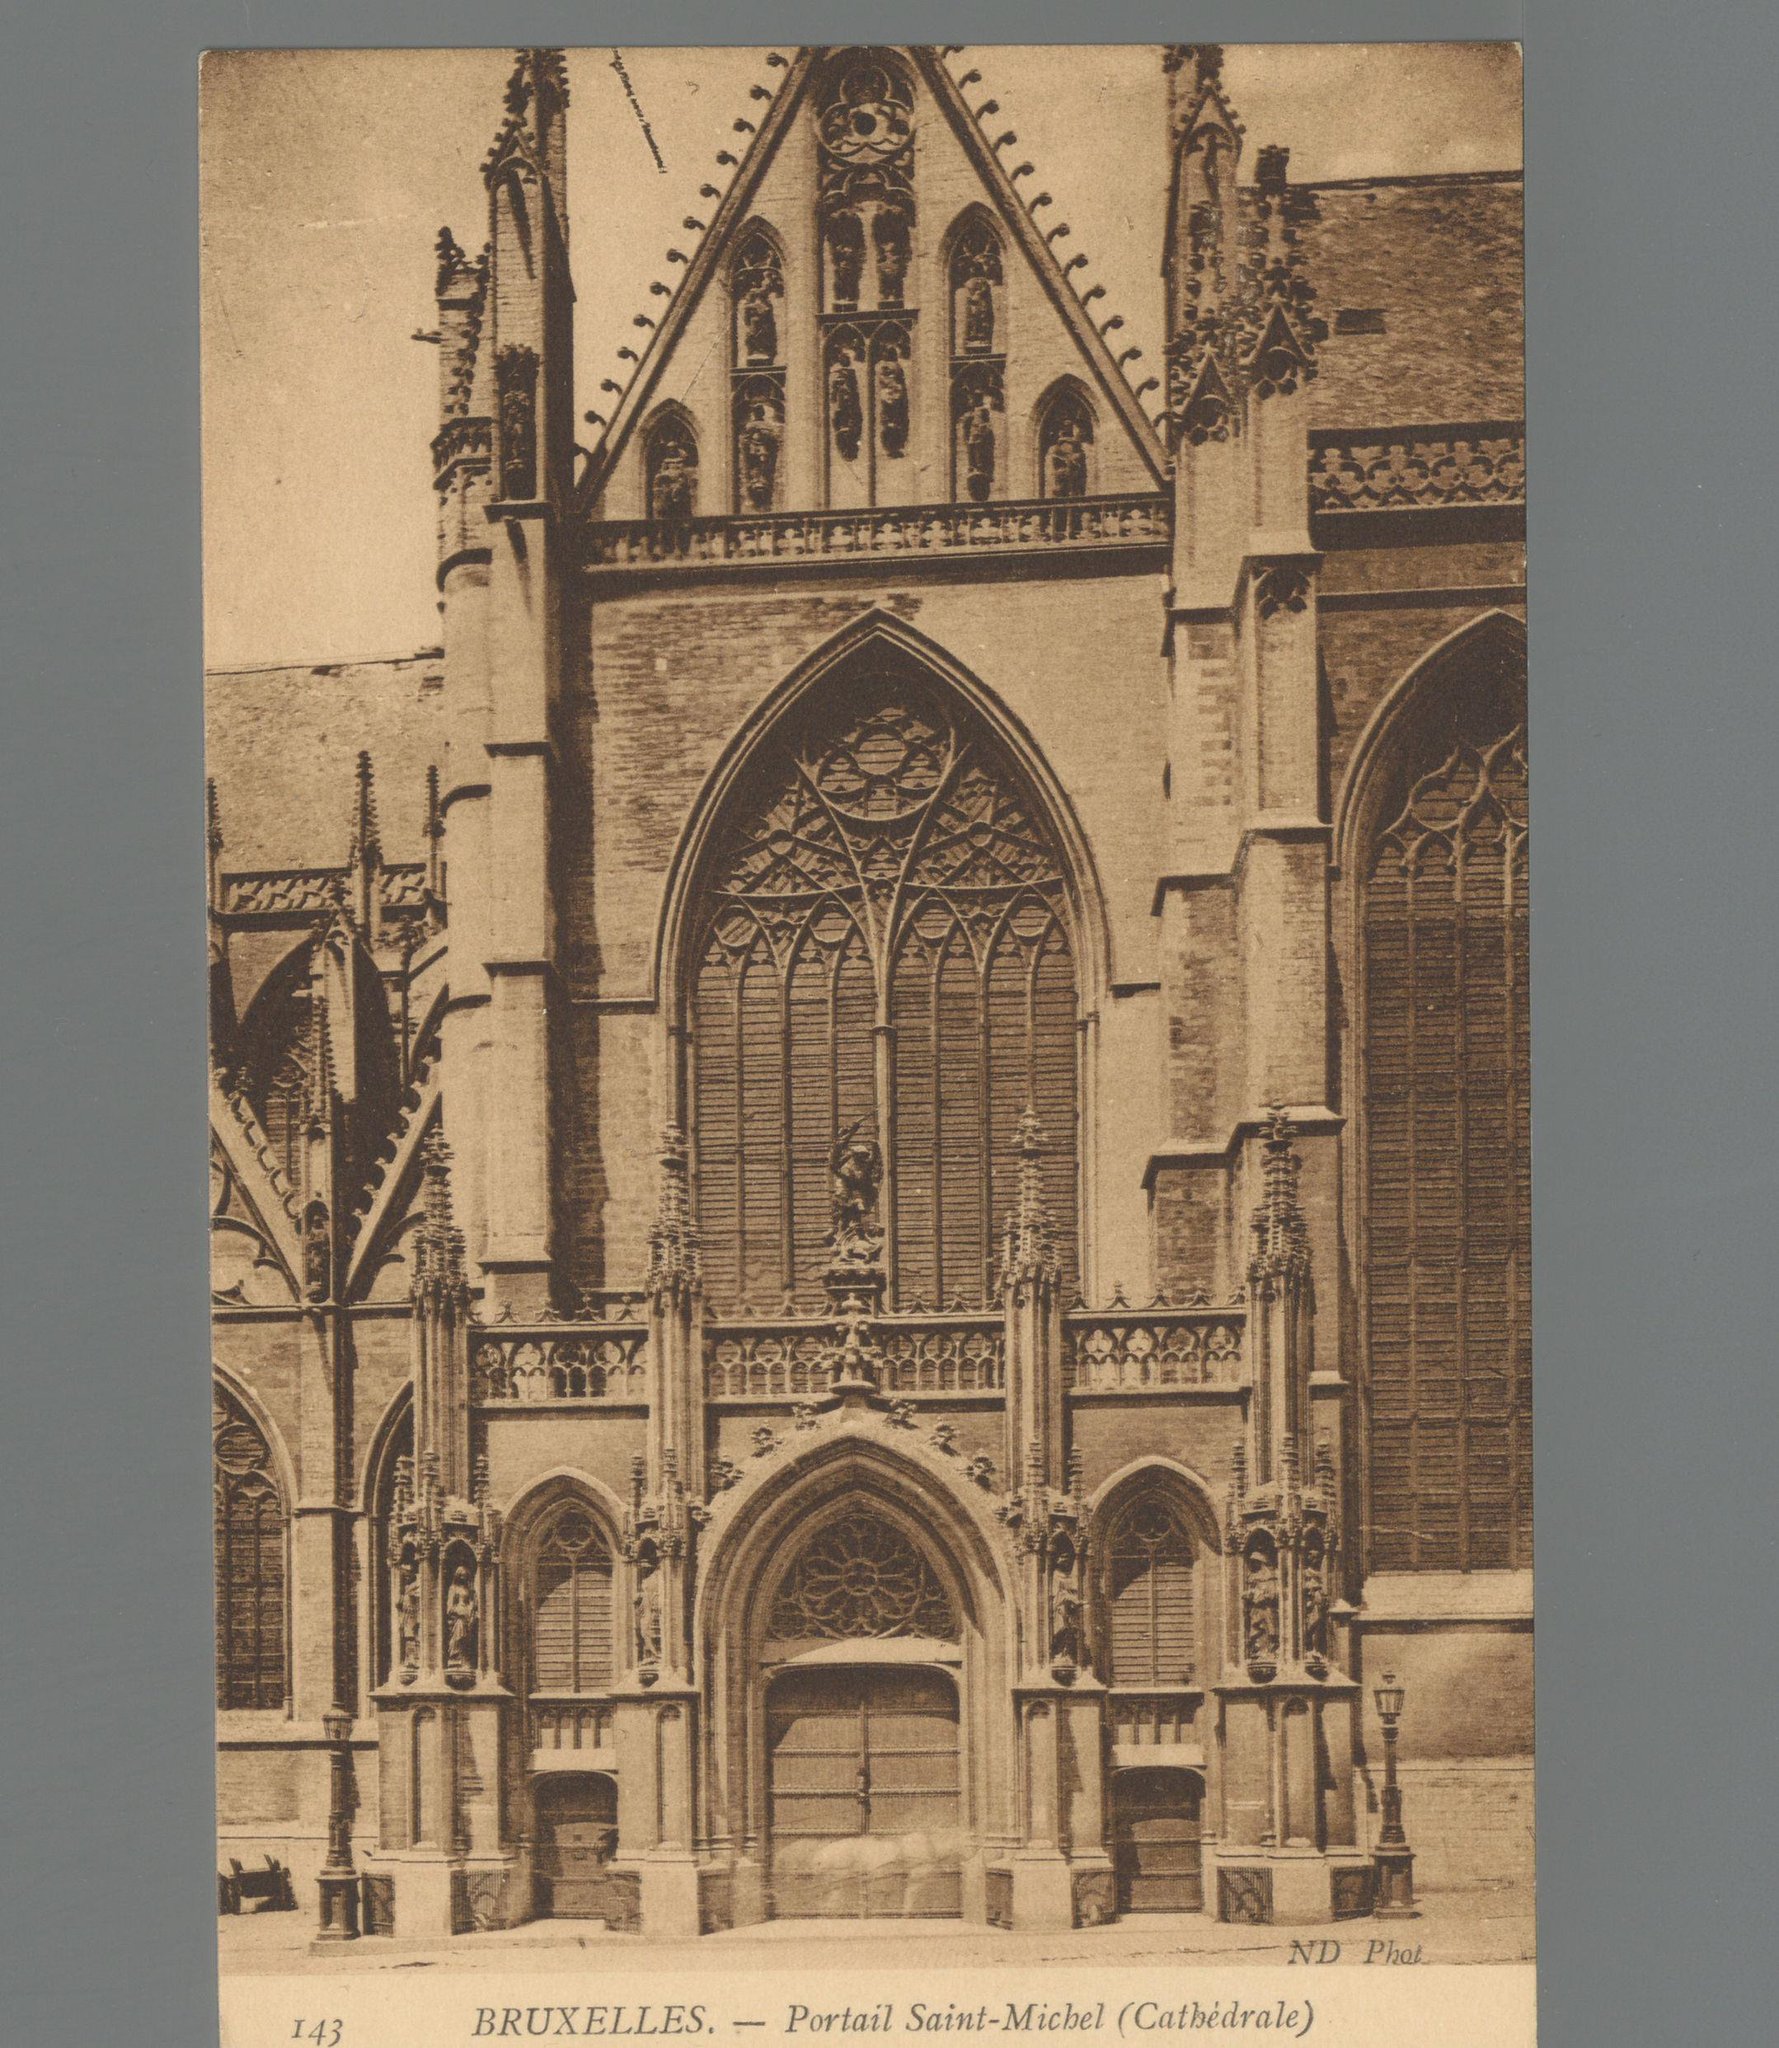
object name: photomechanical print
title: Bruxelles. Portail Saint-Michel (Cathédrale)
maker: Anonymous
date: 1906-1918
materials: cardboard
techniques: photograph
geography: brussels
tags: parts of church exterior and annexes: portal